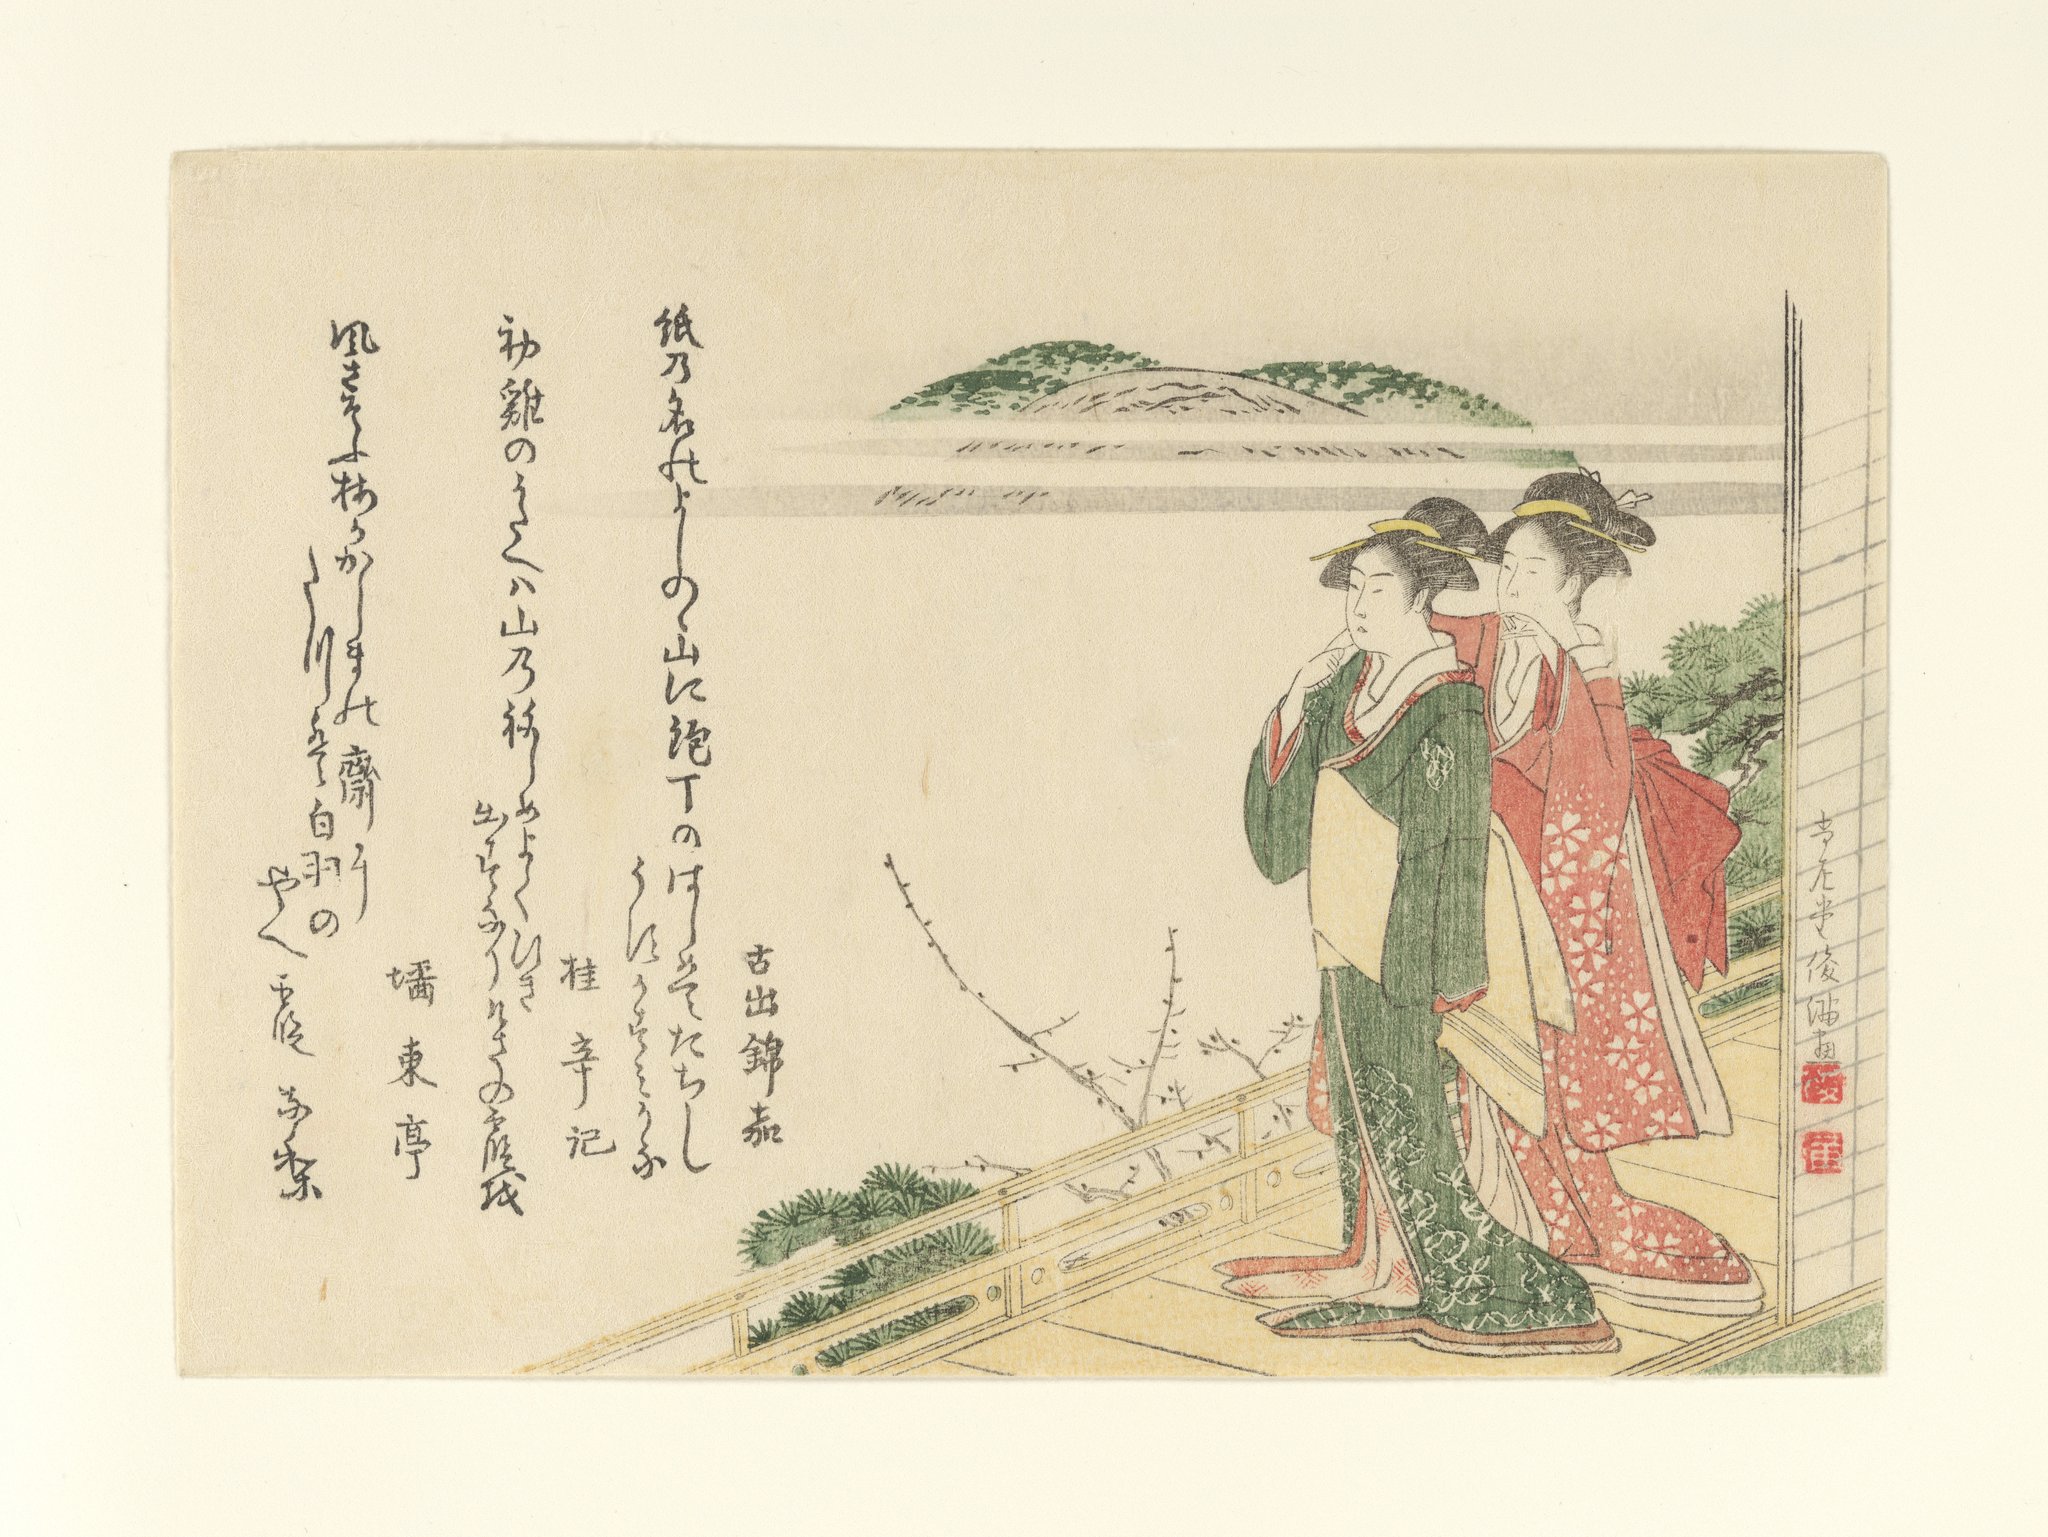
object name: print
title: Two Young Women on a Veranda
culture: japanese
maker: kubo shunman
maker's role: artist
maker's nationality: japanese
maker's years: 1757-1820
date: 1796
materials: ink, paper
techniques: surimono, woodblock print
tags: women